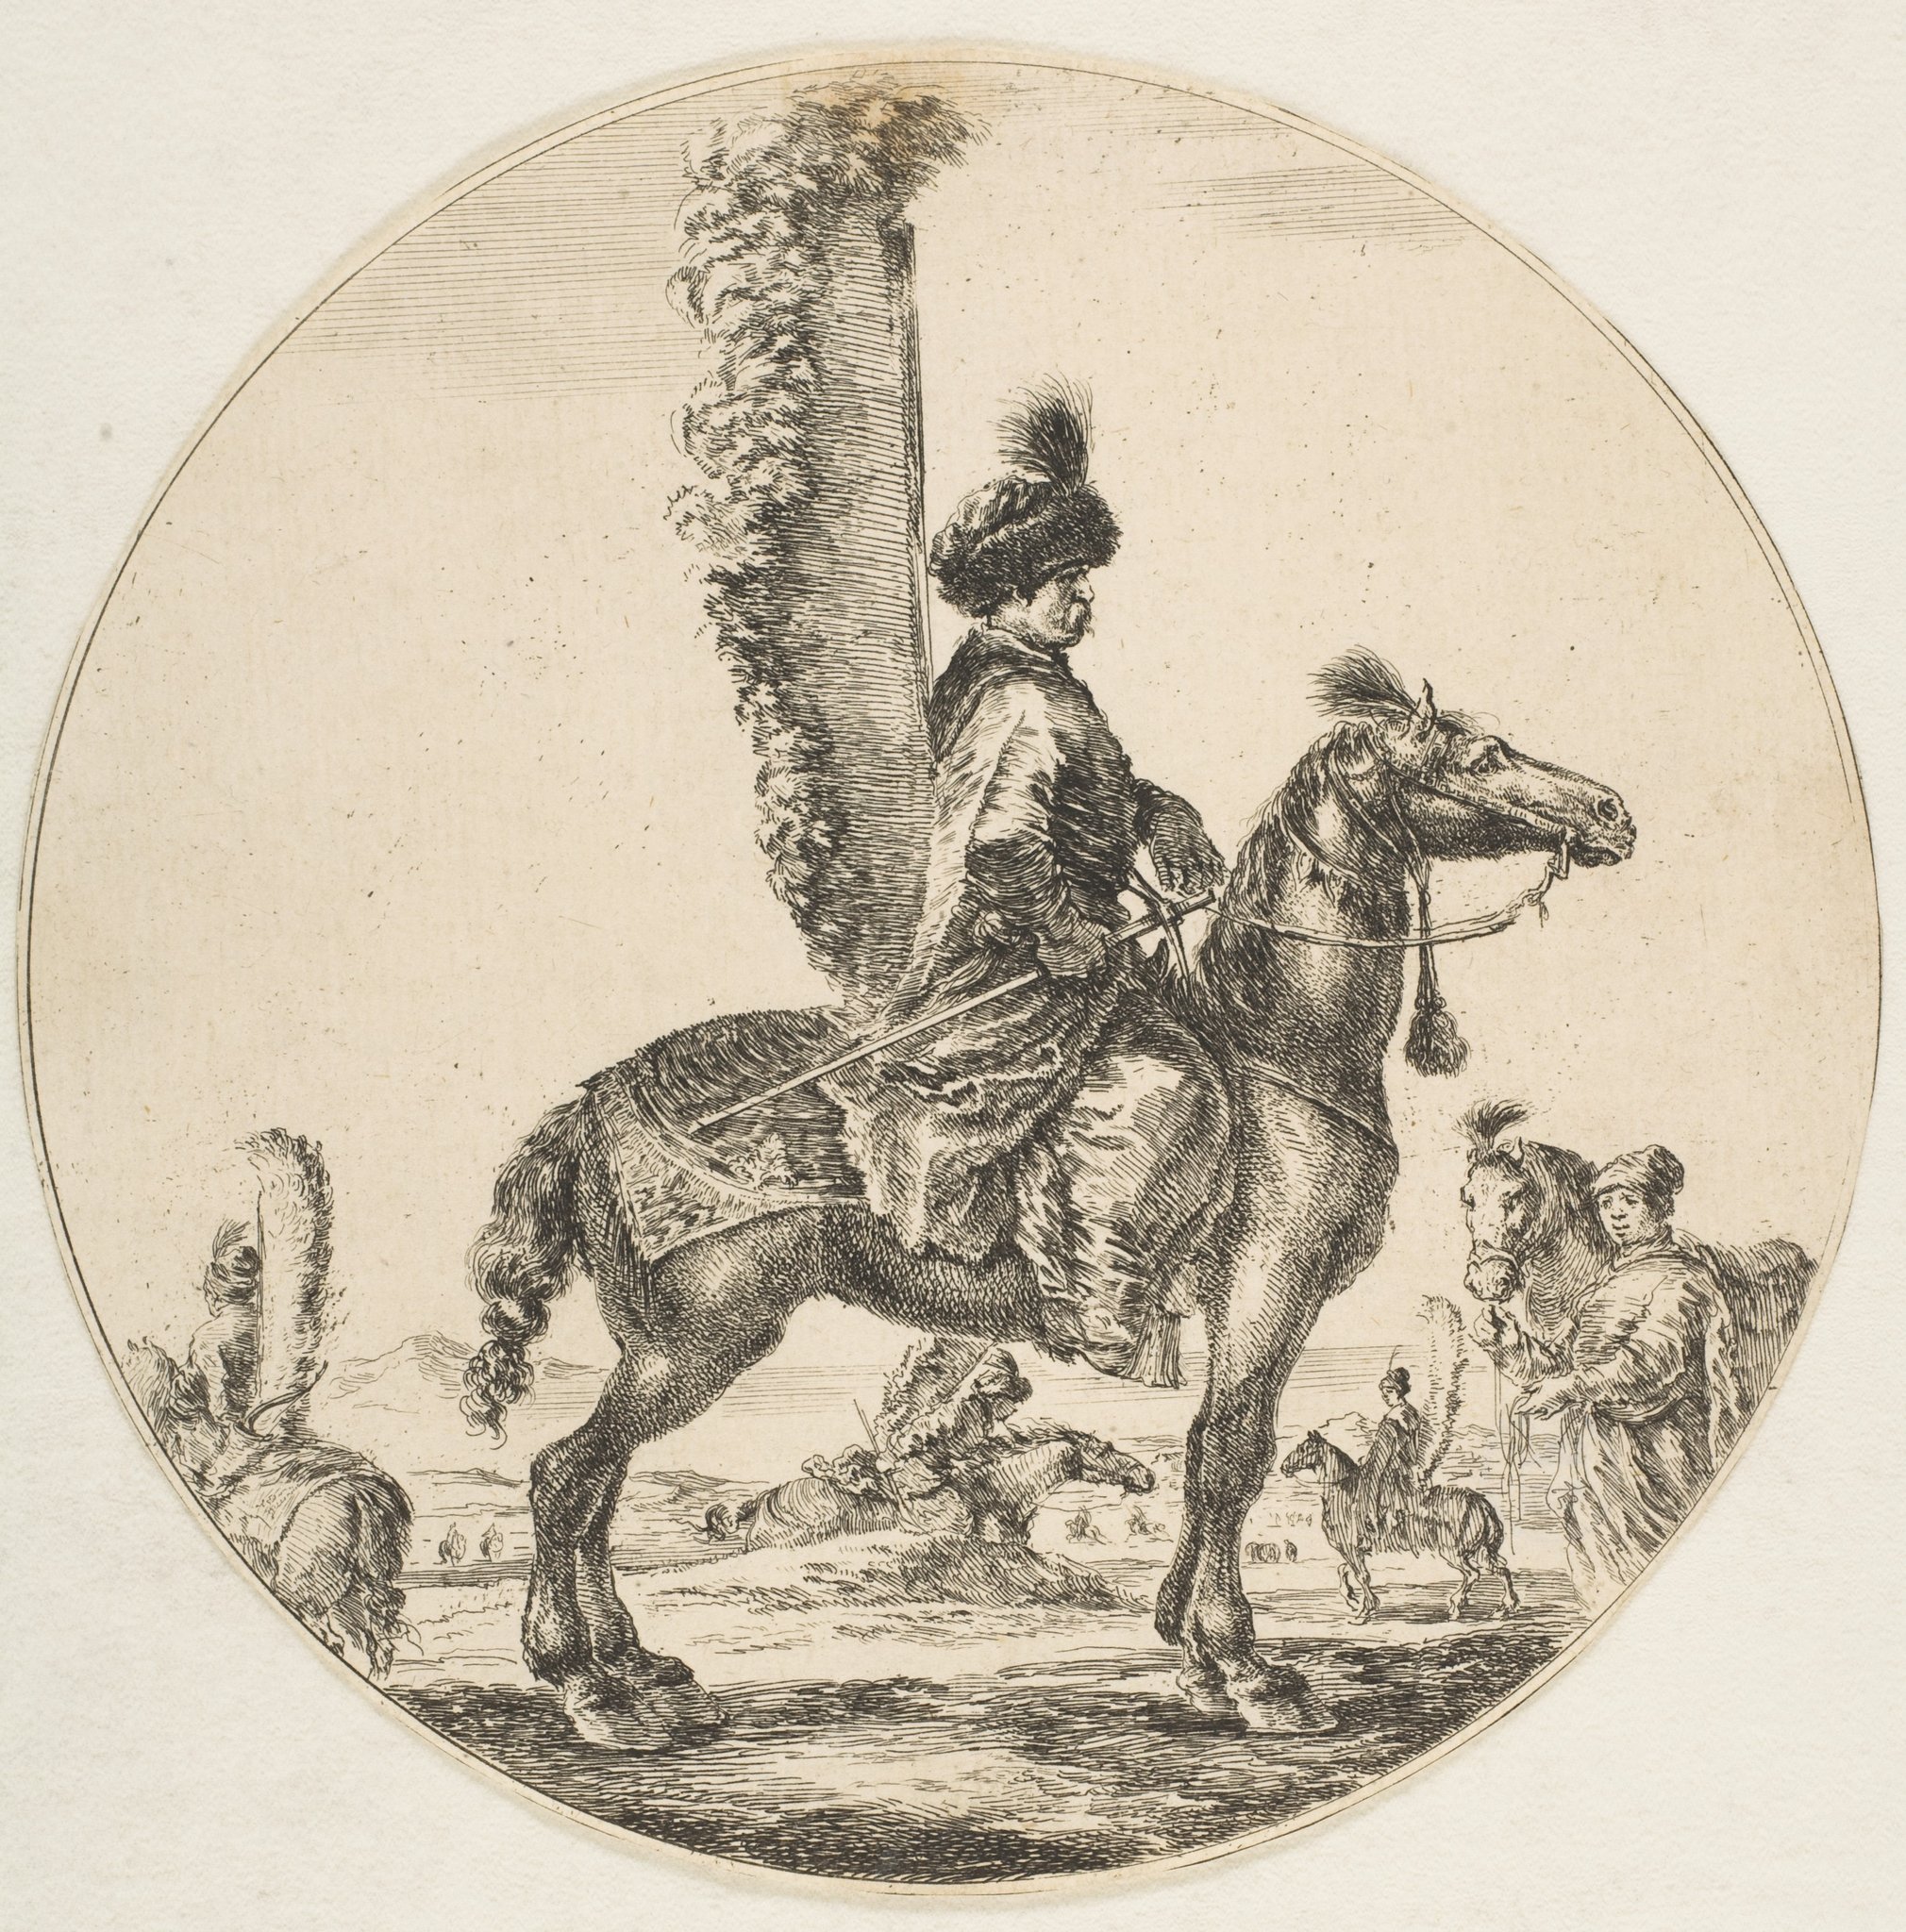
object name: print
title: Polish hussar in profile facing right with wings attached to his back, a circular composition, from "Figures on Horseback" (Cavaliers nègres, polonais et hongrois)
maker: stefano della bella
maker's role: artist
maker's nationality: italian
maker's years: 1610-1664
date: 1651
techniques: etching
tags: swords,men,profiles,horses